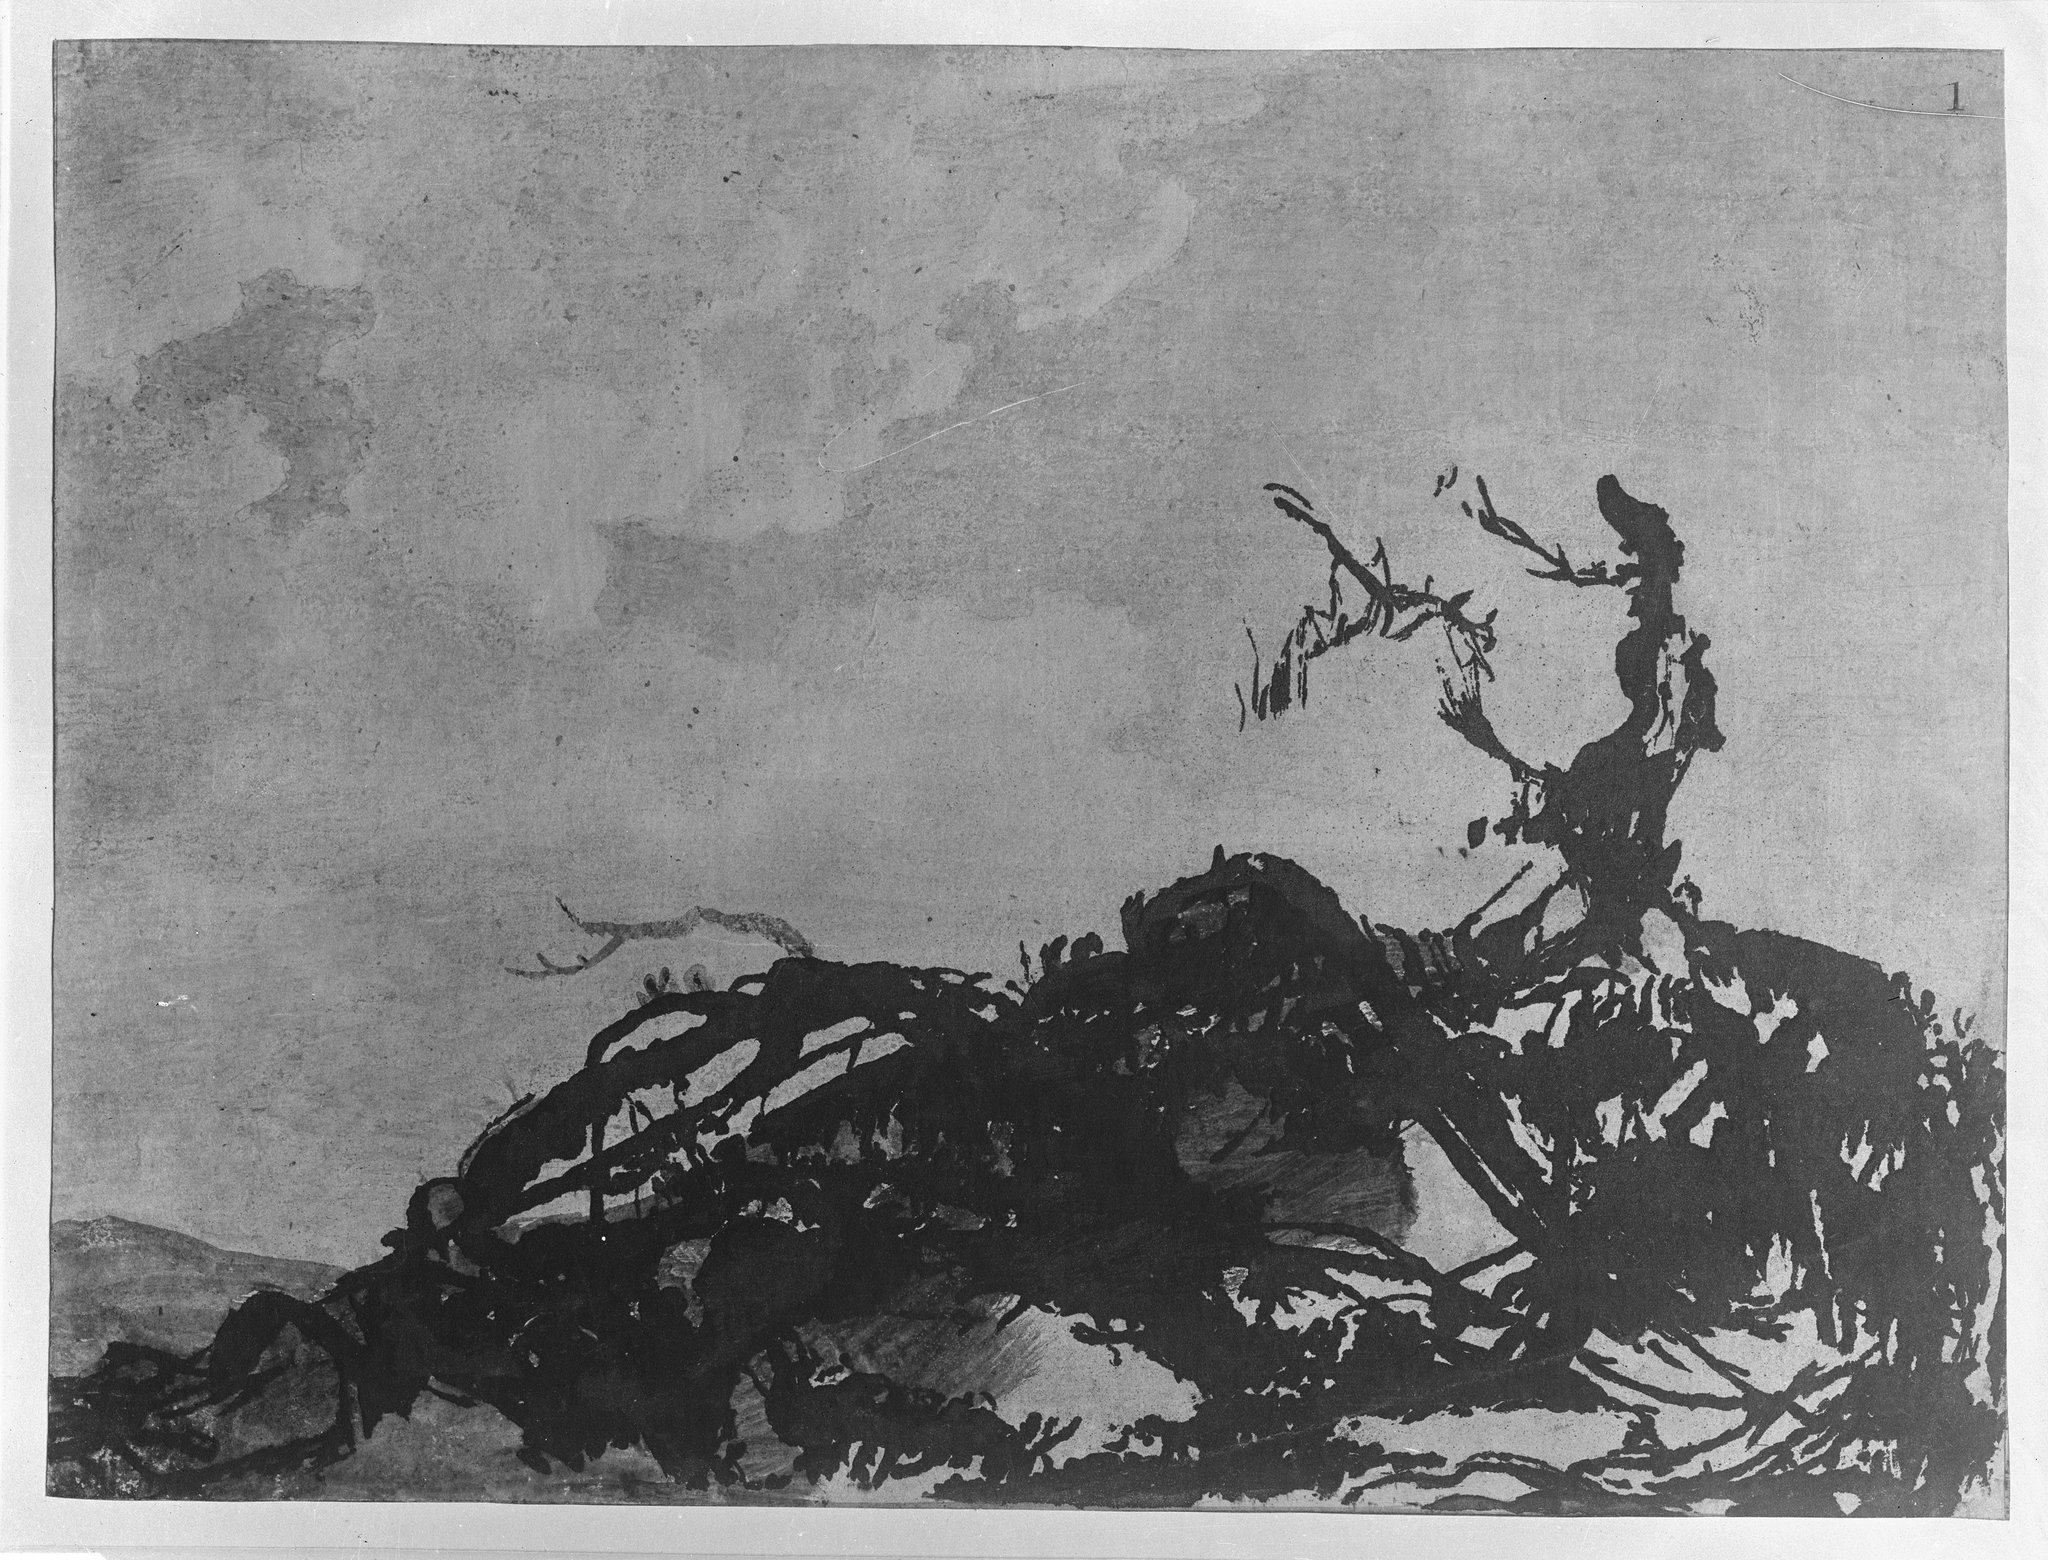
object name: print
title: The Fallen Tree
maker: alexander cozens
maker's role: artist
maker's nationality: british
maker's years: 1717-1786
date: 1785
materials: graphite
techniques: aquatint, brush, wash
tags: trees